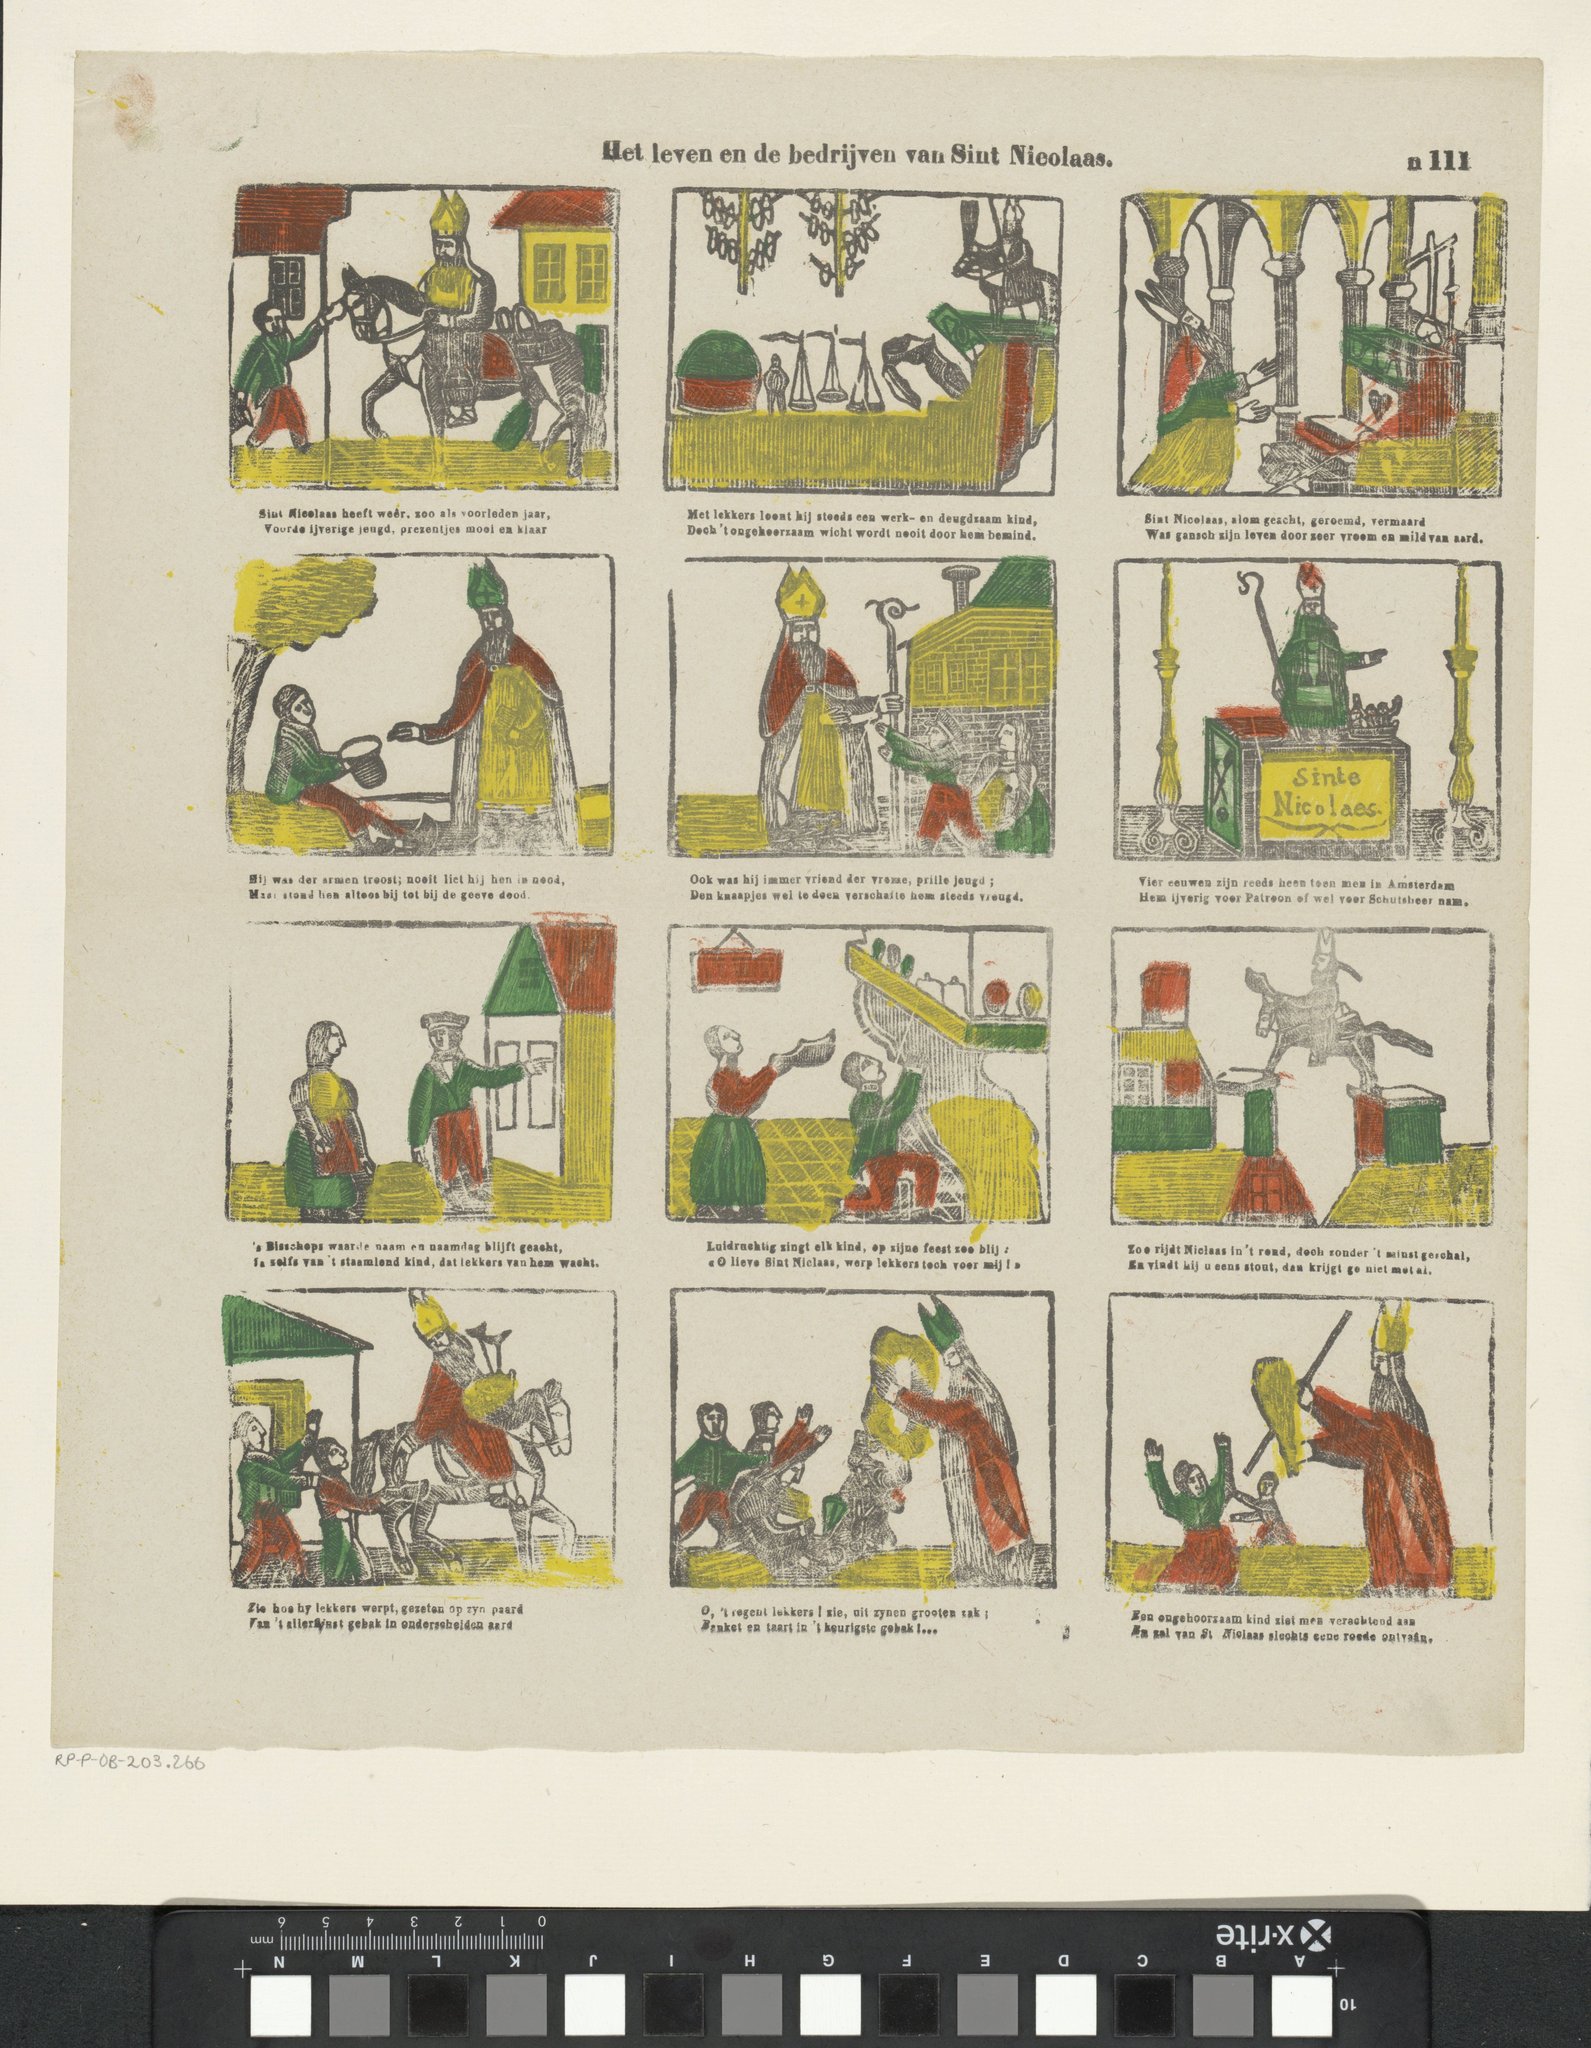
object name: popular print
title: Het leven en de bedrijven van Sint Nicolaas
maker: Anonymous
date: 1856-1900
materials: paper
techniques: colour, letterpress printing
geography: turnhout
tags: the bishop nicholas of myra (or bari); possible attributes: anchor, boat, three golden balls (on a book), three purses, three children in a tub, three maidens, festivities on st. nicholas (eve) (december 5)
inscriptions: collector's mark: Lugt 2760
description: Blad met 12 voorstellingen over het leven van Sint Nicolaas. Onder elke afbeelding een tweeregelig vers. Genummerd rechtsboven: n 111.